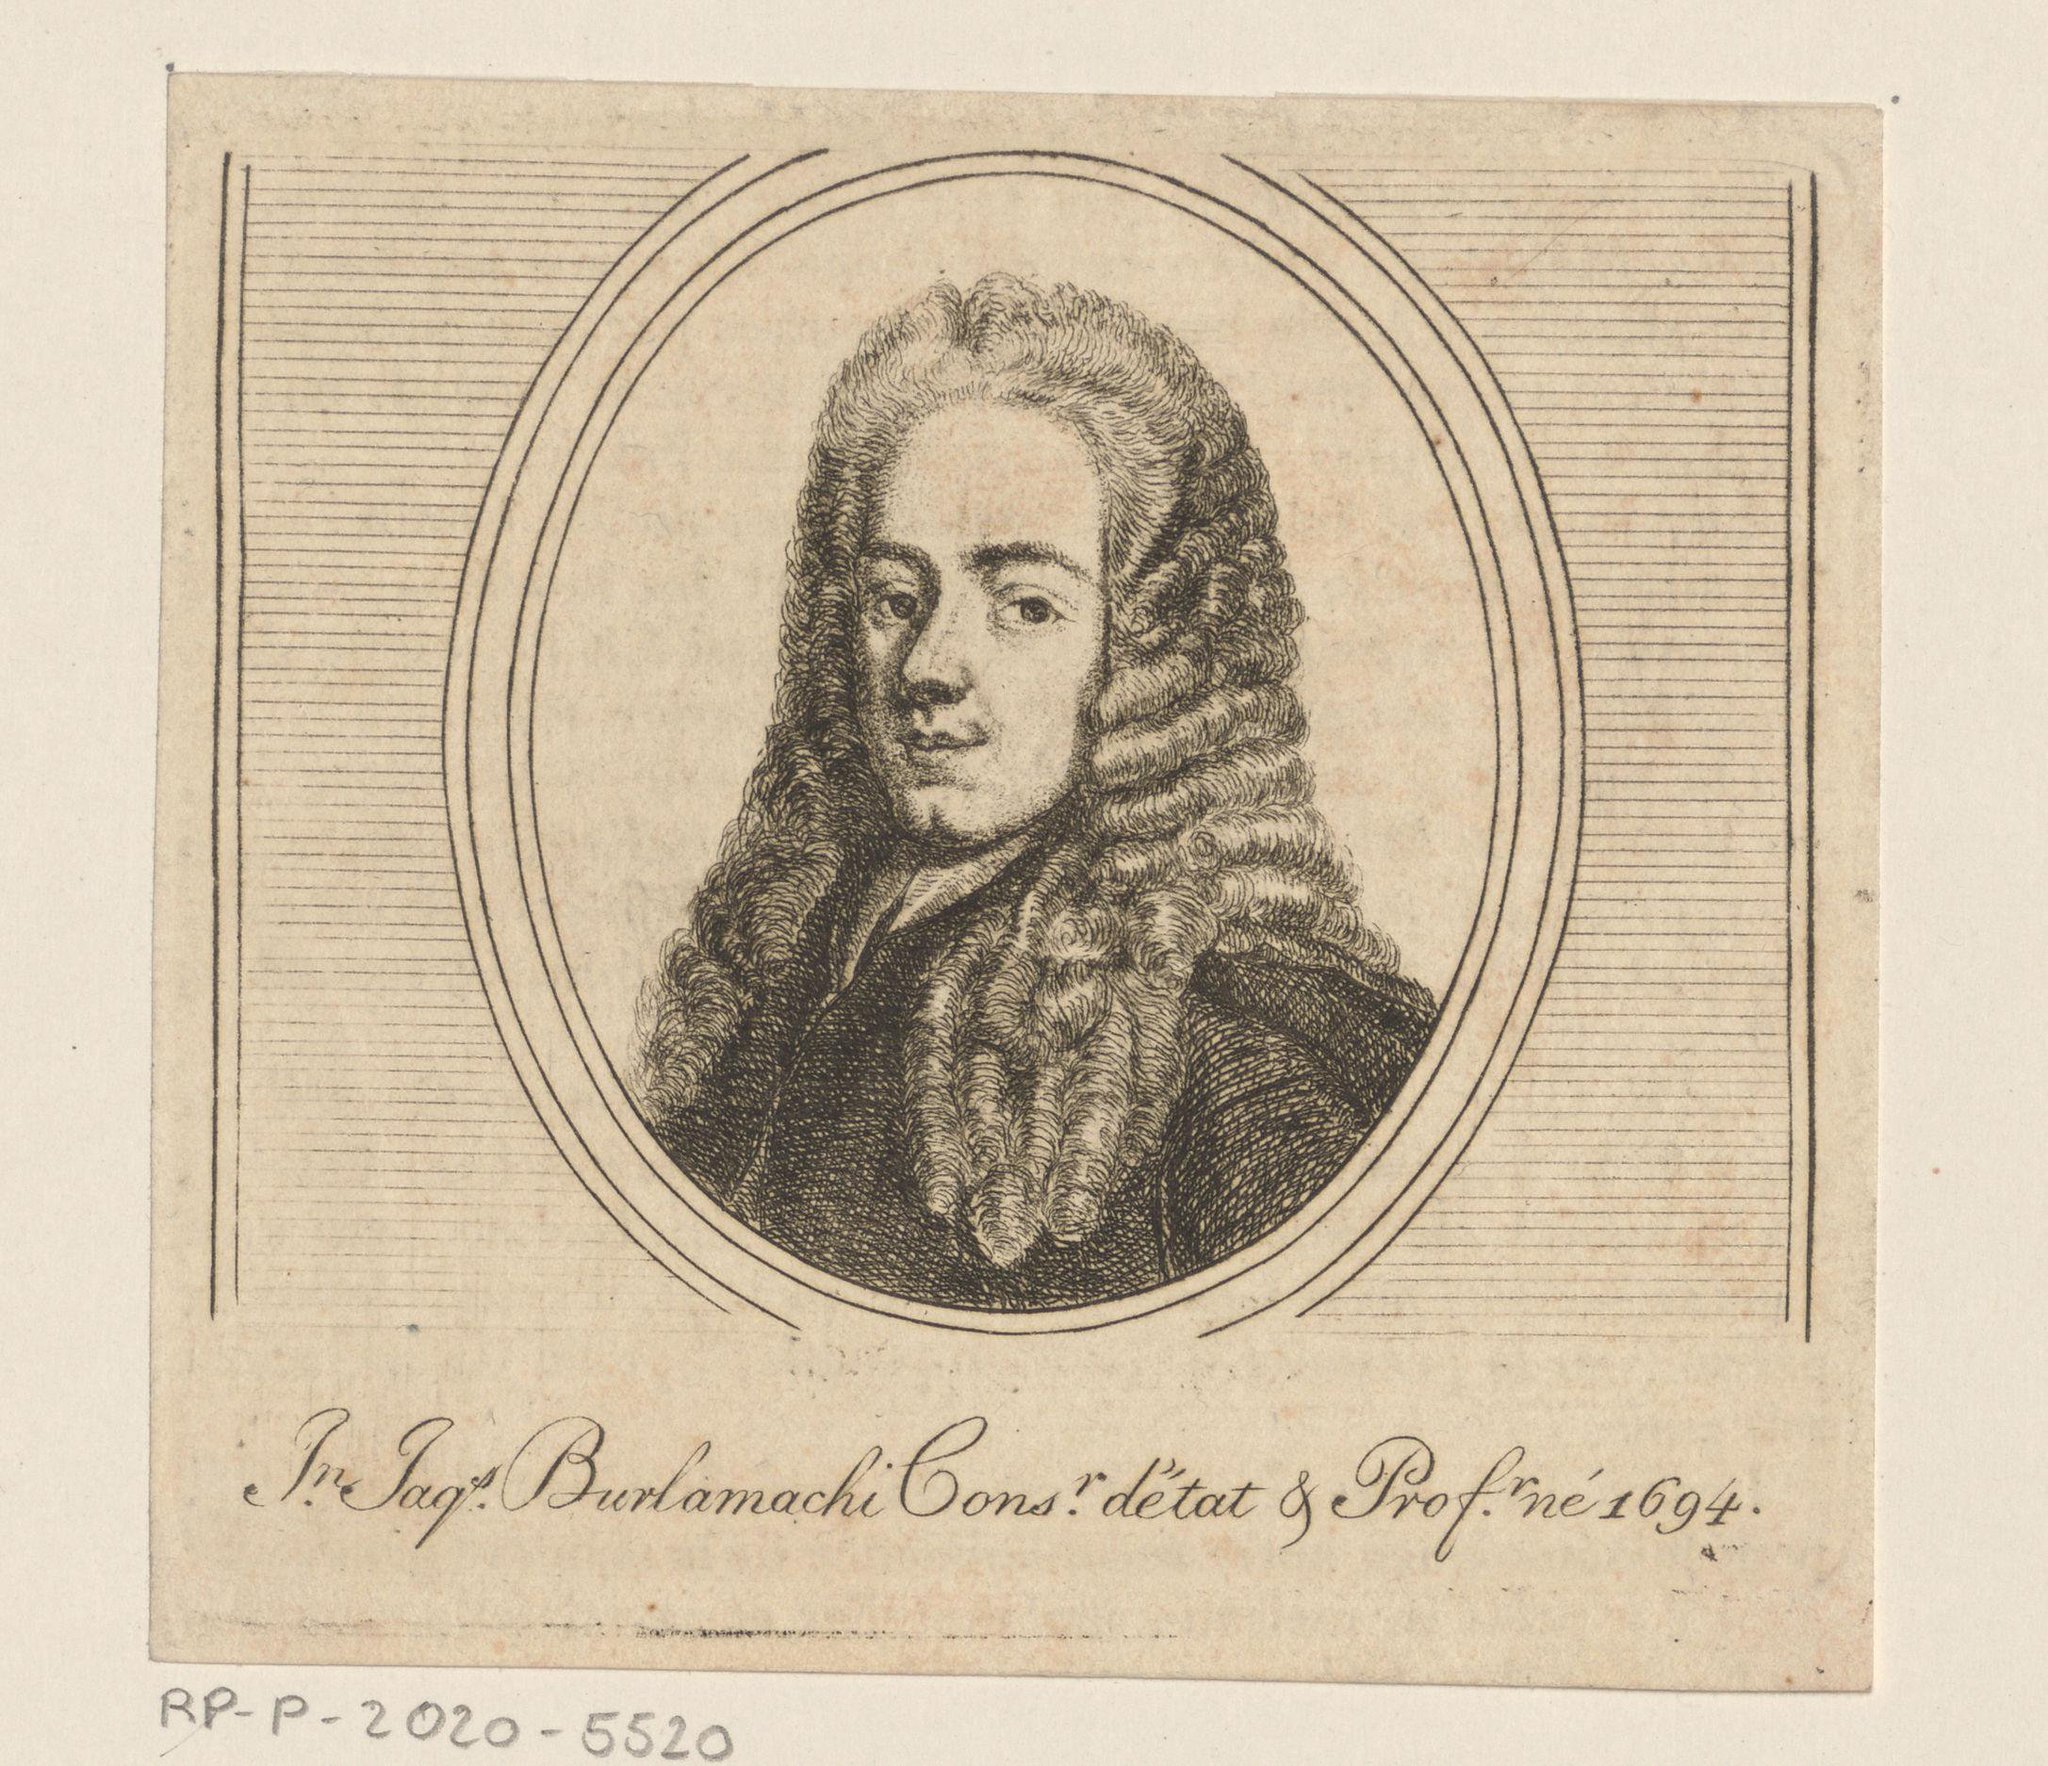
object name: book illustration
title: Portret van Jean-Jacques Burlamaqui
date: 1815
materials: paper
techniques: engraving, etching, letterpress printing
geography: geneva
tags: historical persons, portrait of a writer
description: Prent uit: Fragmens biographiques et historiques, extraits des registres du conseil d'État de la République de Genève (...). Genève: Gaspard Joël Manget en Abraham Cherbuliez, 1815, p. 297.